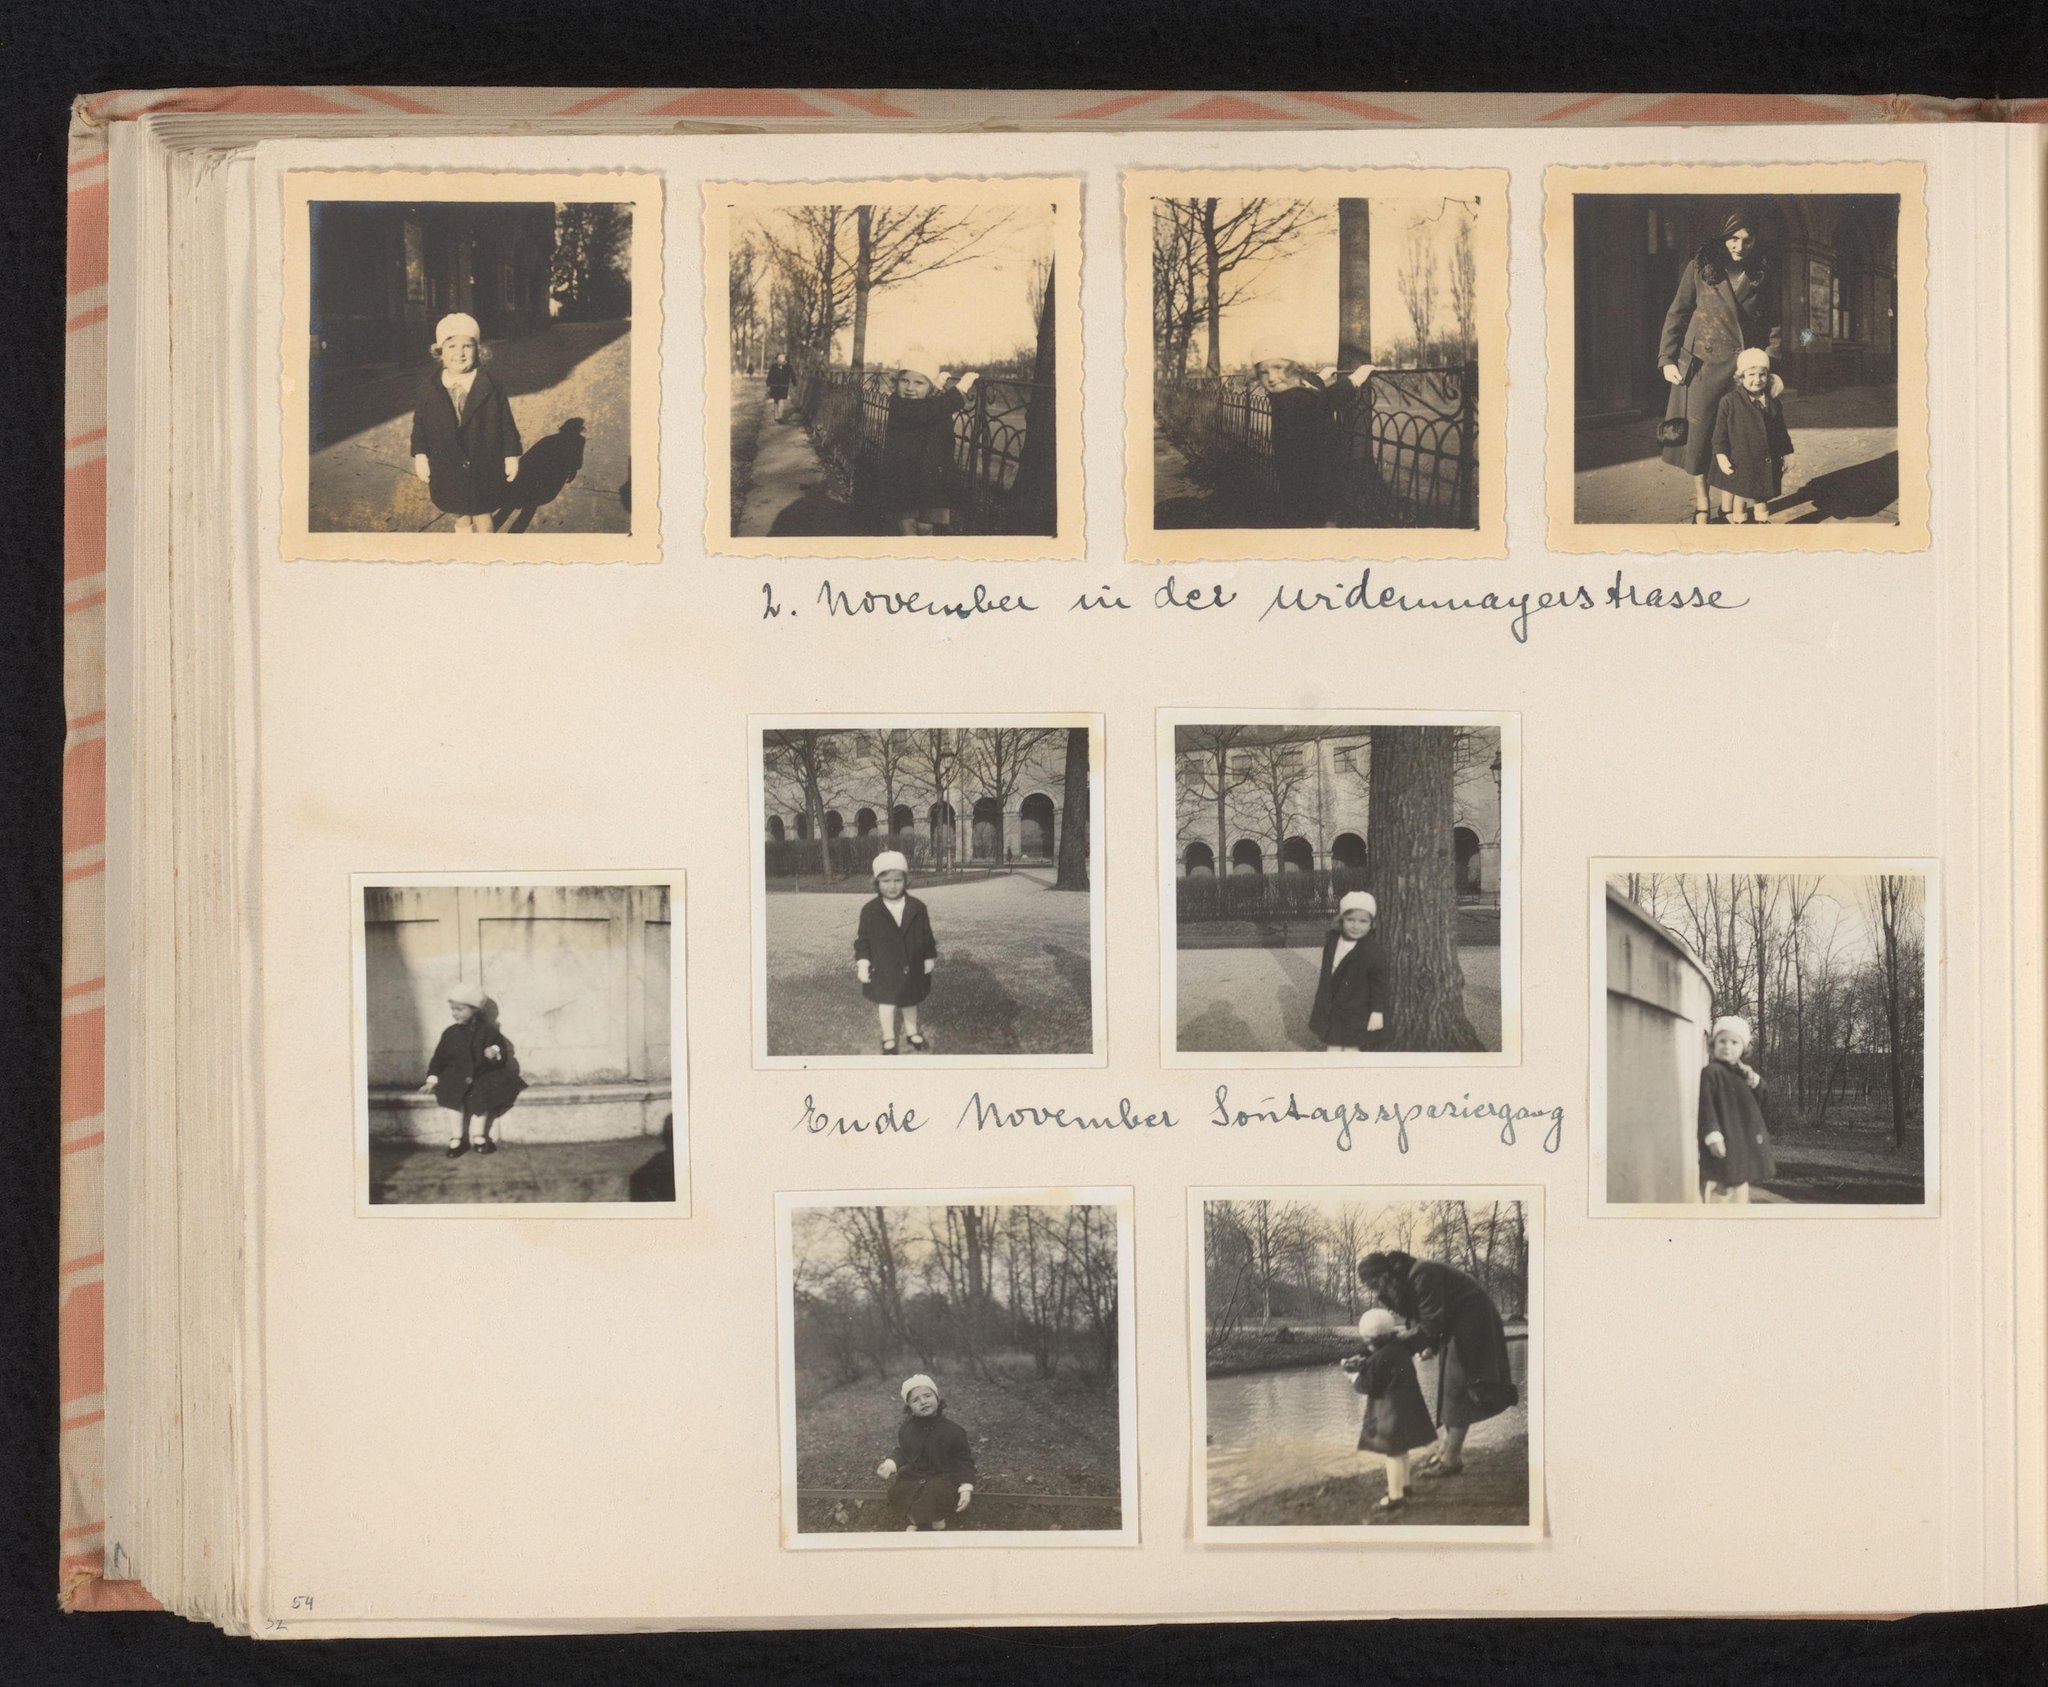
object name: photograph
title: Isabel Wachenheimer op de Widenmayerstrasse en tijdens een zondagswandeling, november 1930, München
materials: paper, photographic support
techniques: gelatin silver print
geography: munich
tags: leiden, isabel wachenheimer-elon, family life at home, infant, baby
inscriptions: inscription: ‘2. November in der Widenmayerstrasse//Ende November Sontagsspaziergang’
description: Albumblad met tien foto's. Alle foto's, Isabel Wachenheimer. Foto rechts boven en rechts onder, onbekende vrouw. Onderdeel van het fotoalbum met foto's van Isabel Wachenheimer als kind (1928-1931).